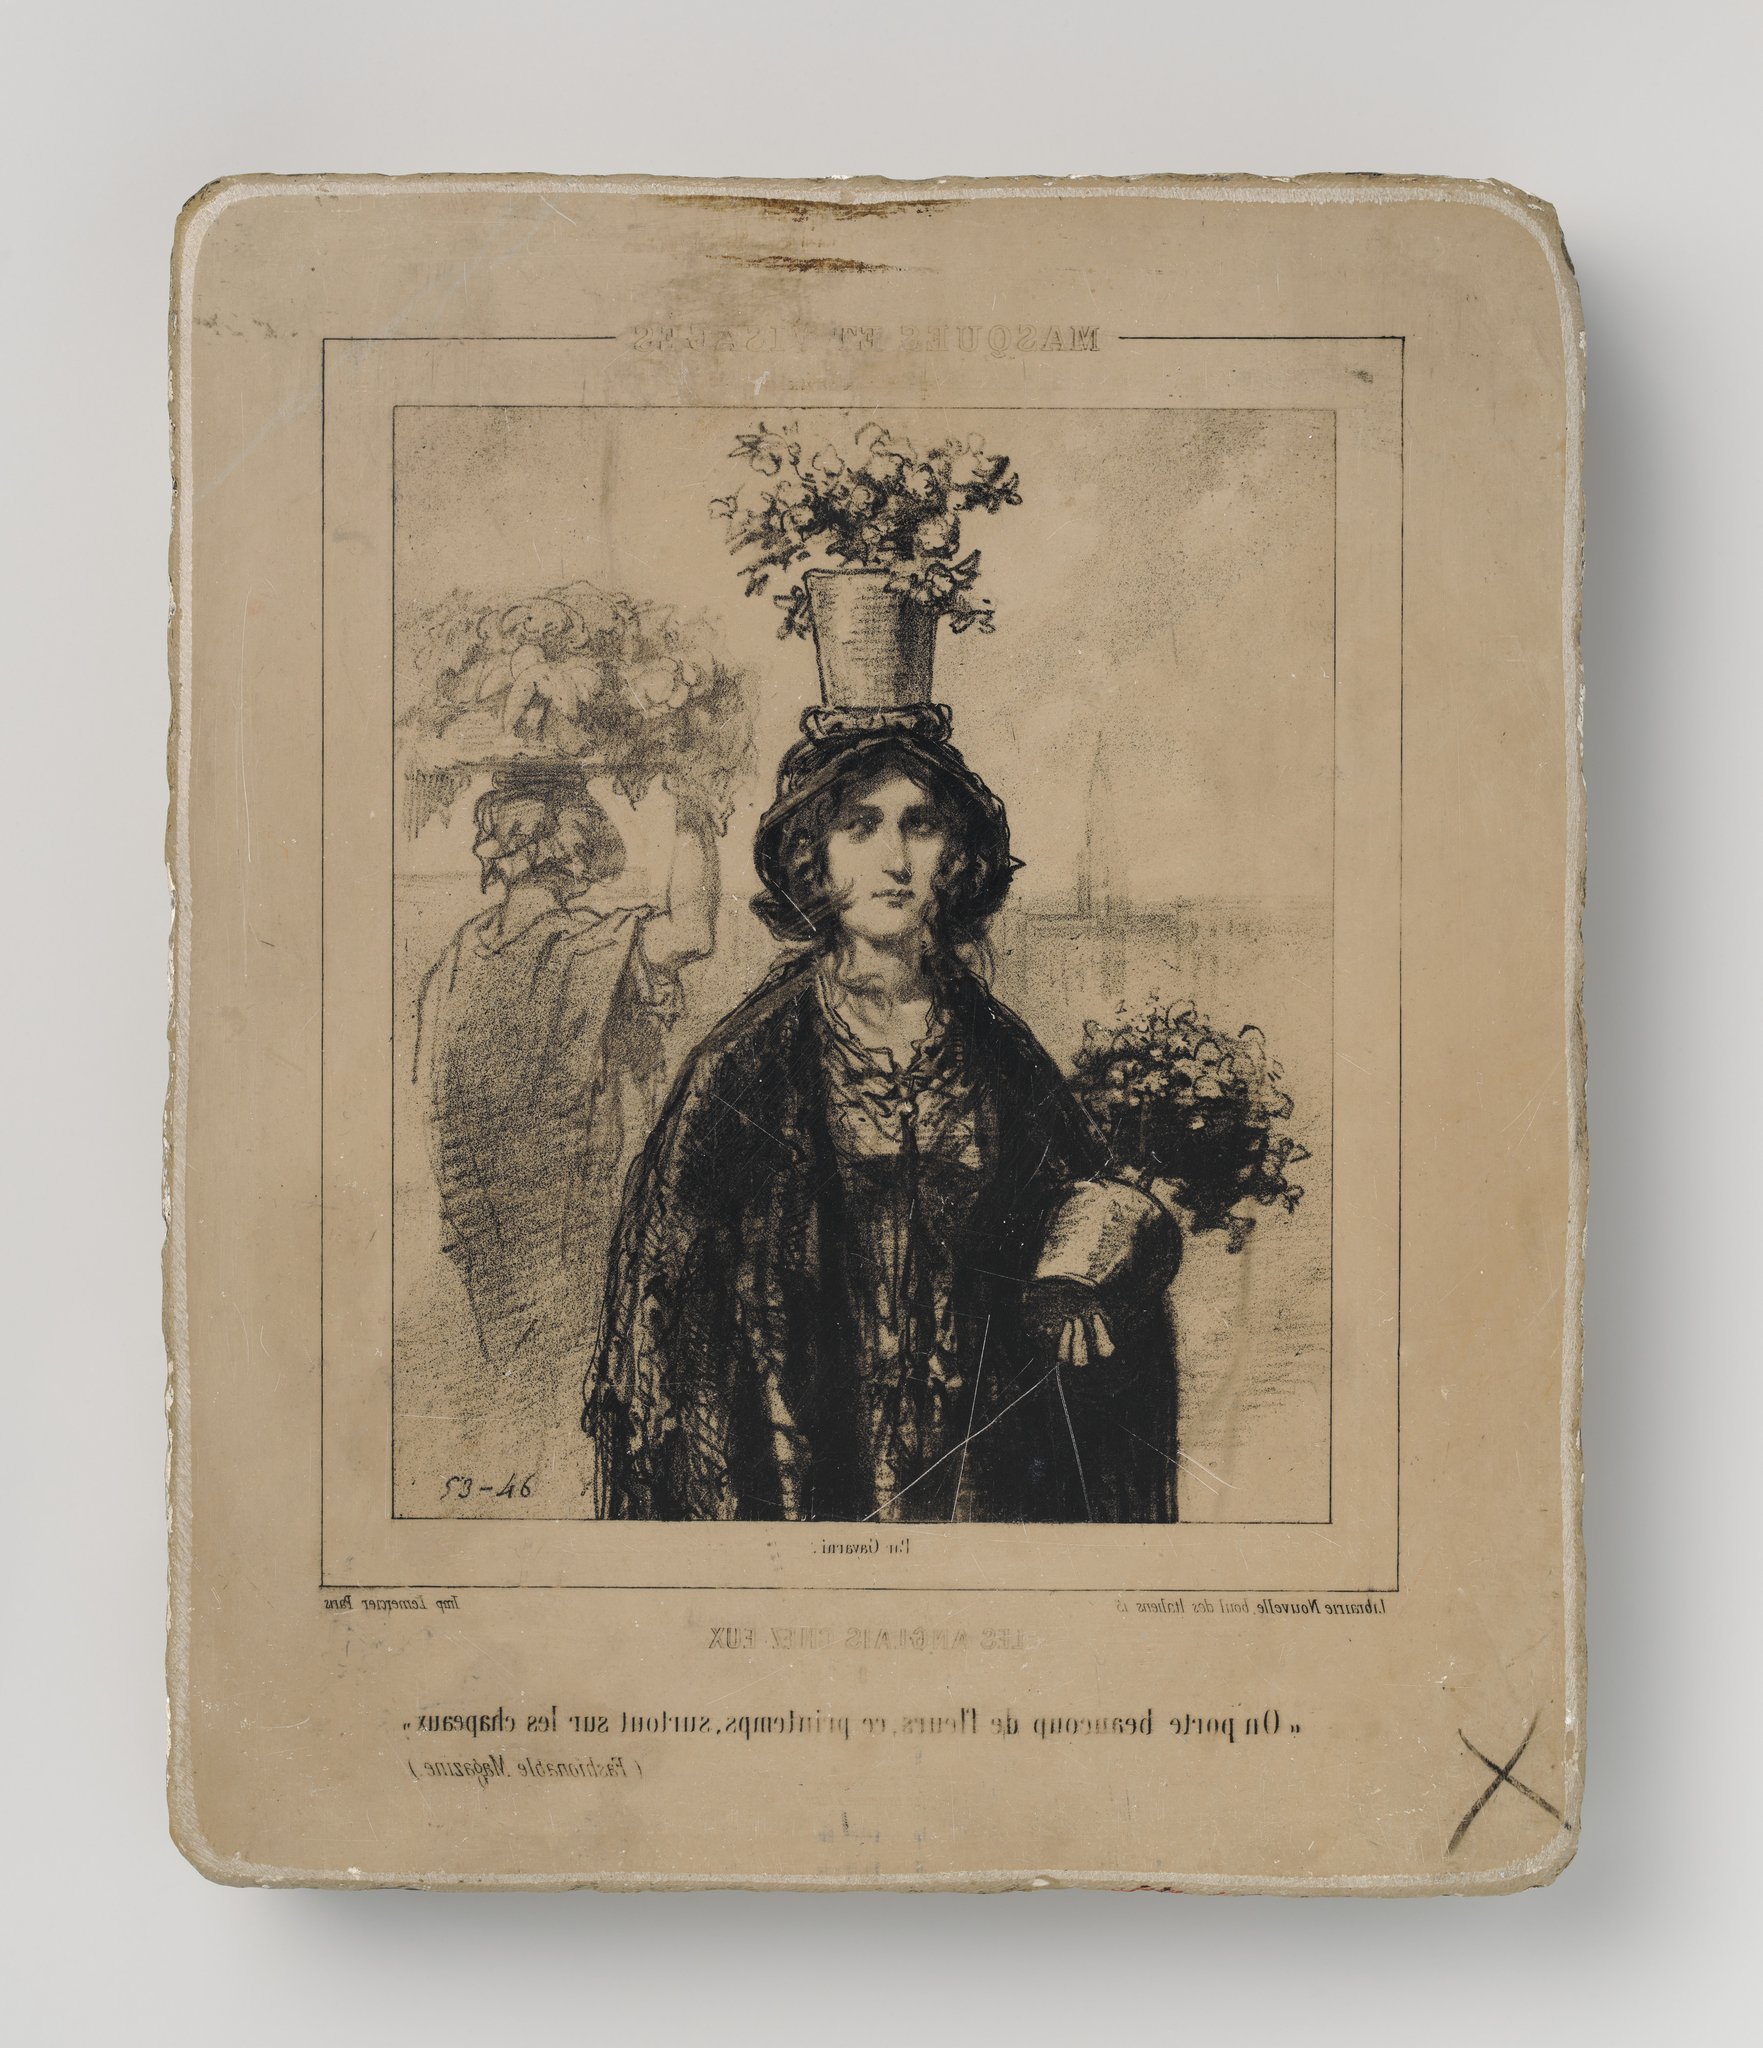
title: "We're wearing lots of flowers this spring, especially on hats" (Fashionable Magazine), plate IX from the suite The English At Home, from Masks and Faces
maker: paul gavarni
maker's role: artist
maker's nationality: french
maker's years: 1804-1866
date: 1853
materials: stone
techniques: lithograph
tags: women,flowers